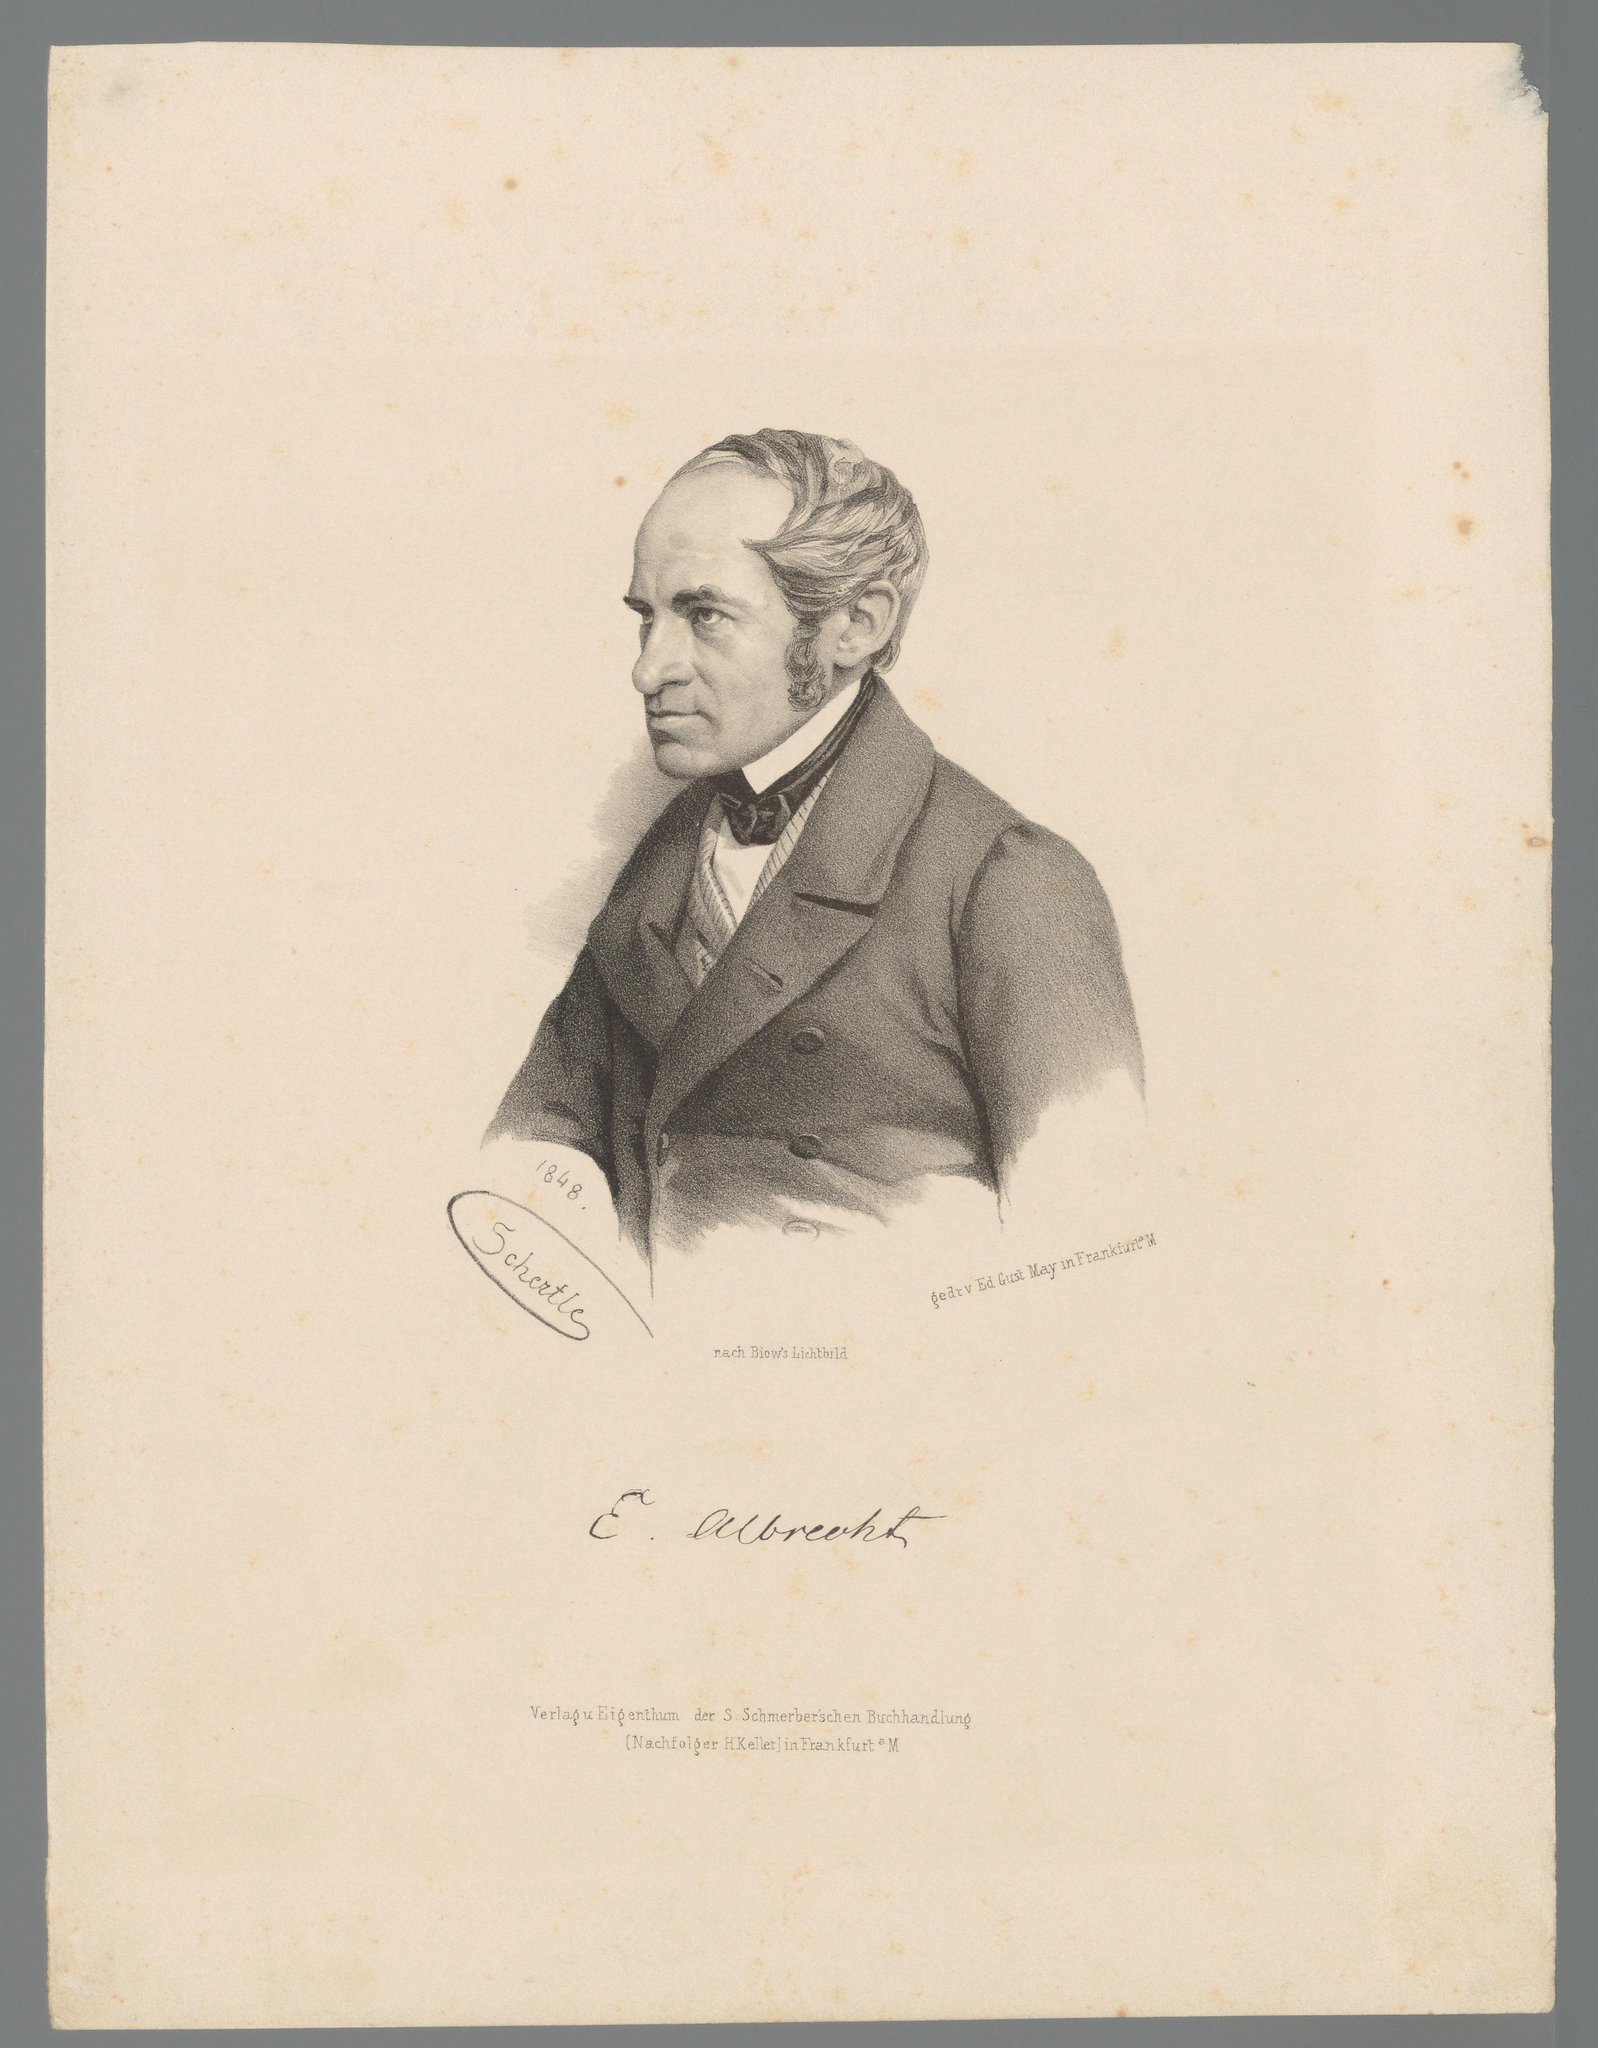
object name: print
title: Portret van Wilhelm Eduard Albrecht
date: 1848-1849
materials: paper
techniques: lithograph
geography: frankfurt am main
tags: adult man, historical persons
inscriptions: collector's mark: Lugt 2228